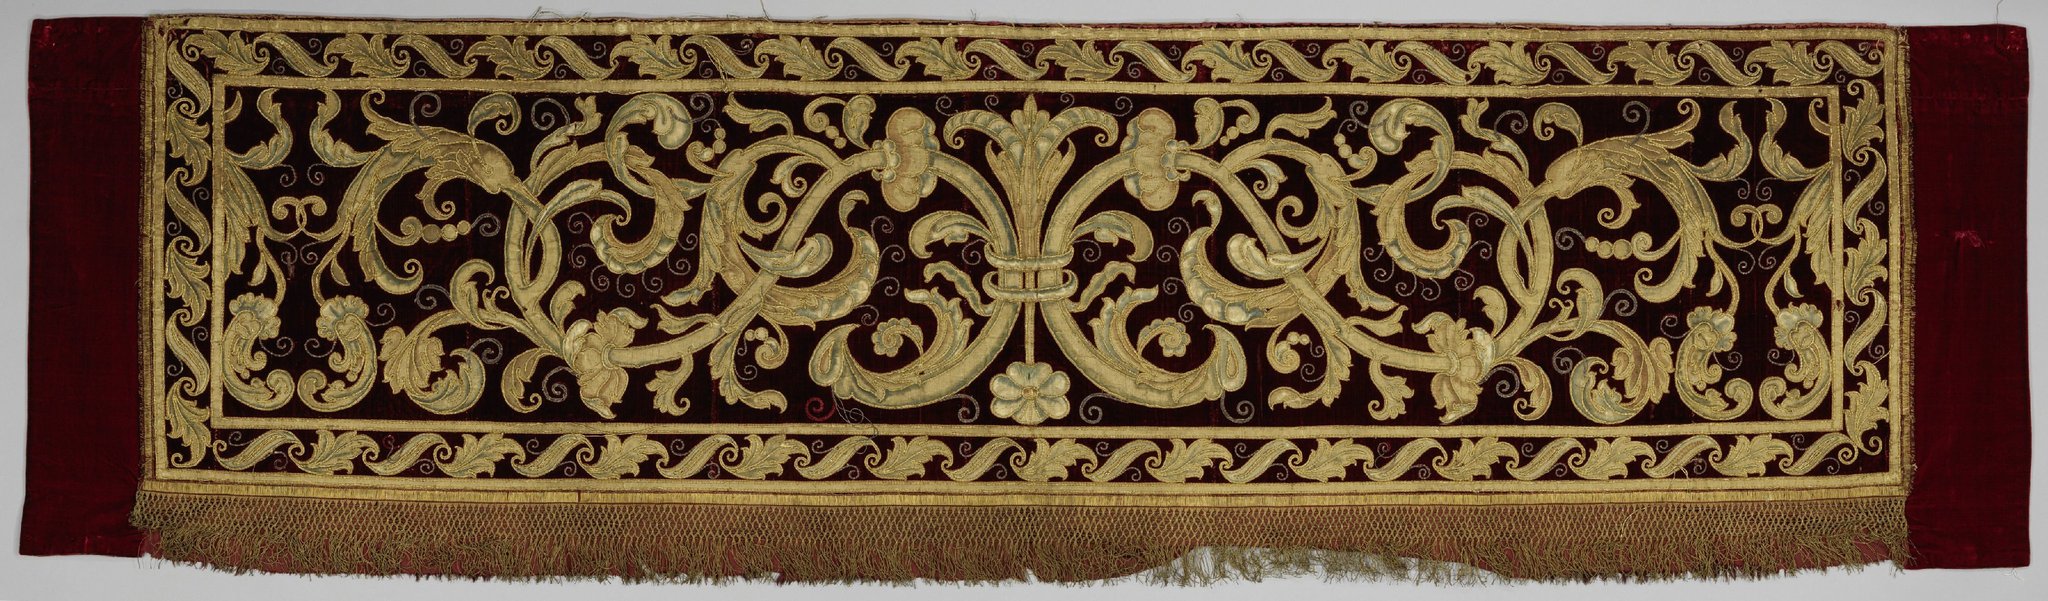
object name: strip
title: Lambrekijn of strook van applicatie borduurwerk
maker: Anonymous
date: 1500-1599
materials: gold thread, silk, velvet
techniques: embroidered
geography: italy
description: Lambrekijn of strook van applicatie-borduurwerk op een wijnrode fluwelen fond. Het patroon heeft symmetrische liggende S-ranken, in het midden samengebonden met een lelie en een roos. De rijk vertakte rank is met bladrozetten bezet en eindigt in voluten van acanthusbladeren en zilveren hechtranken. De strook is afgewerkt met goudpassement en goudfranje langs de onderzijde. De strook hoort bij drie stroken.